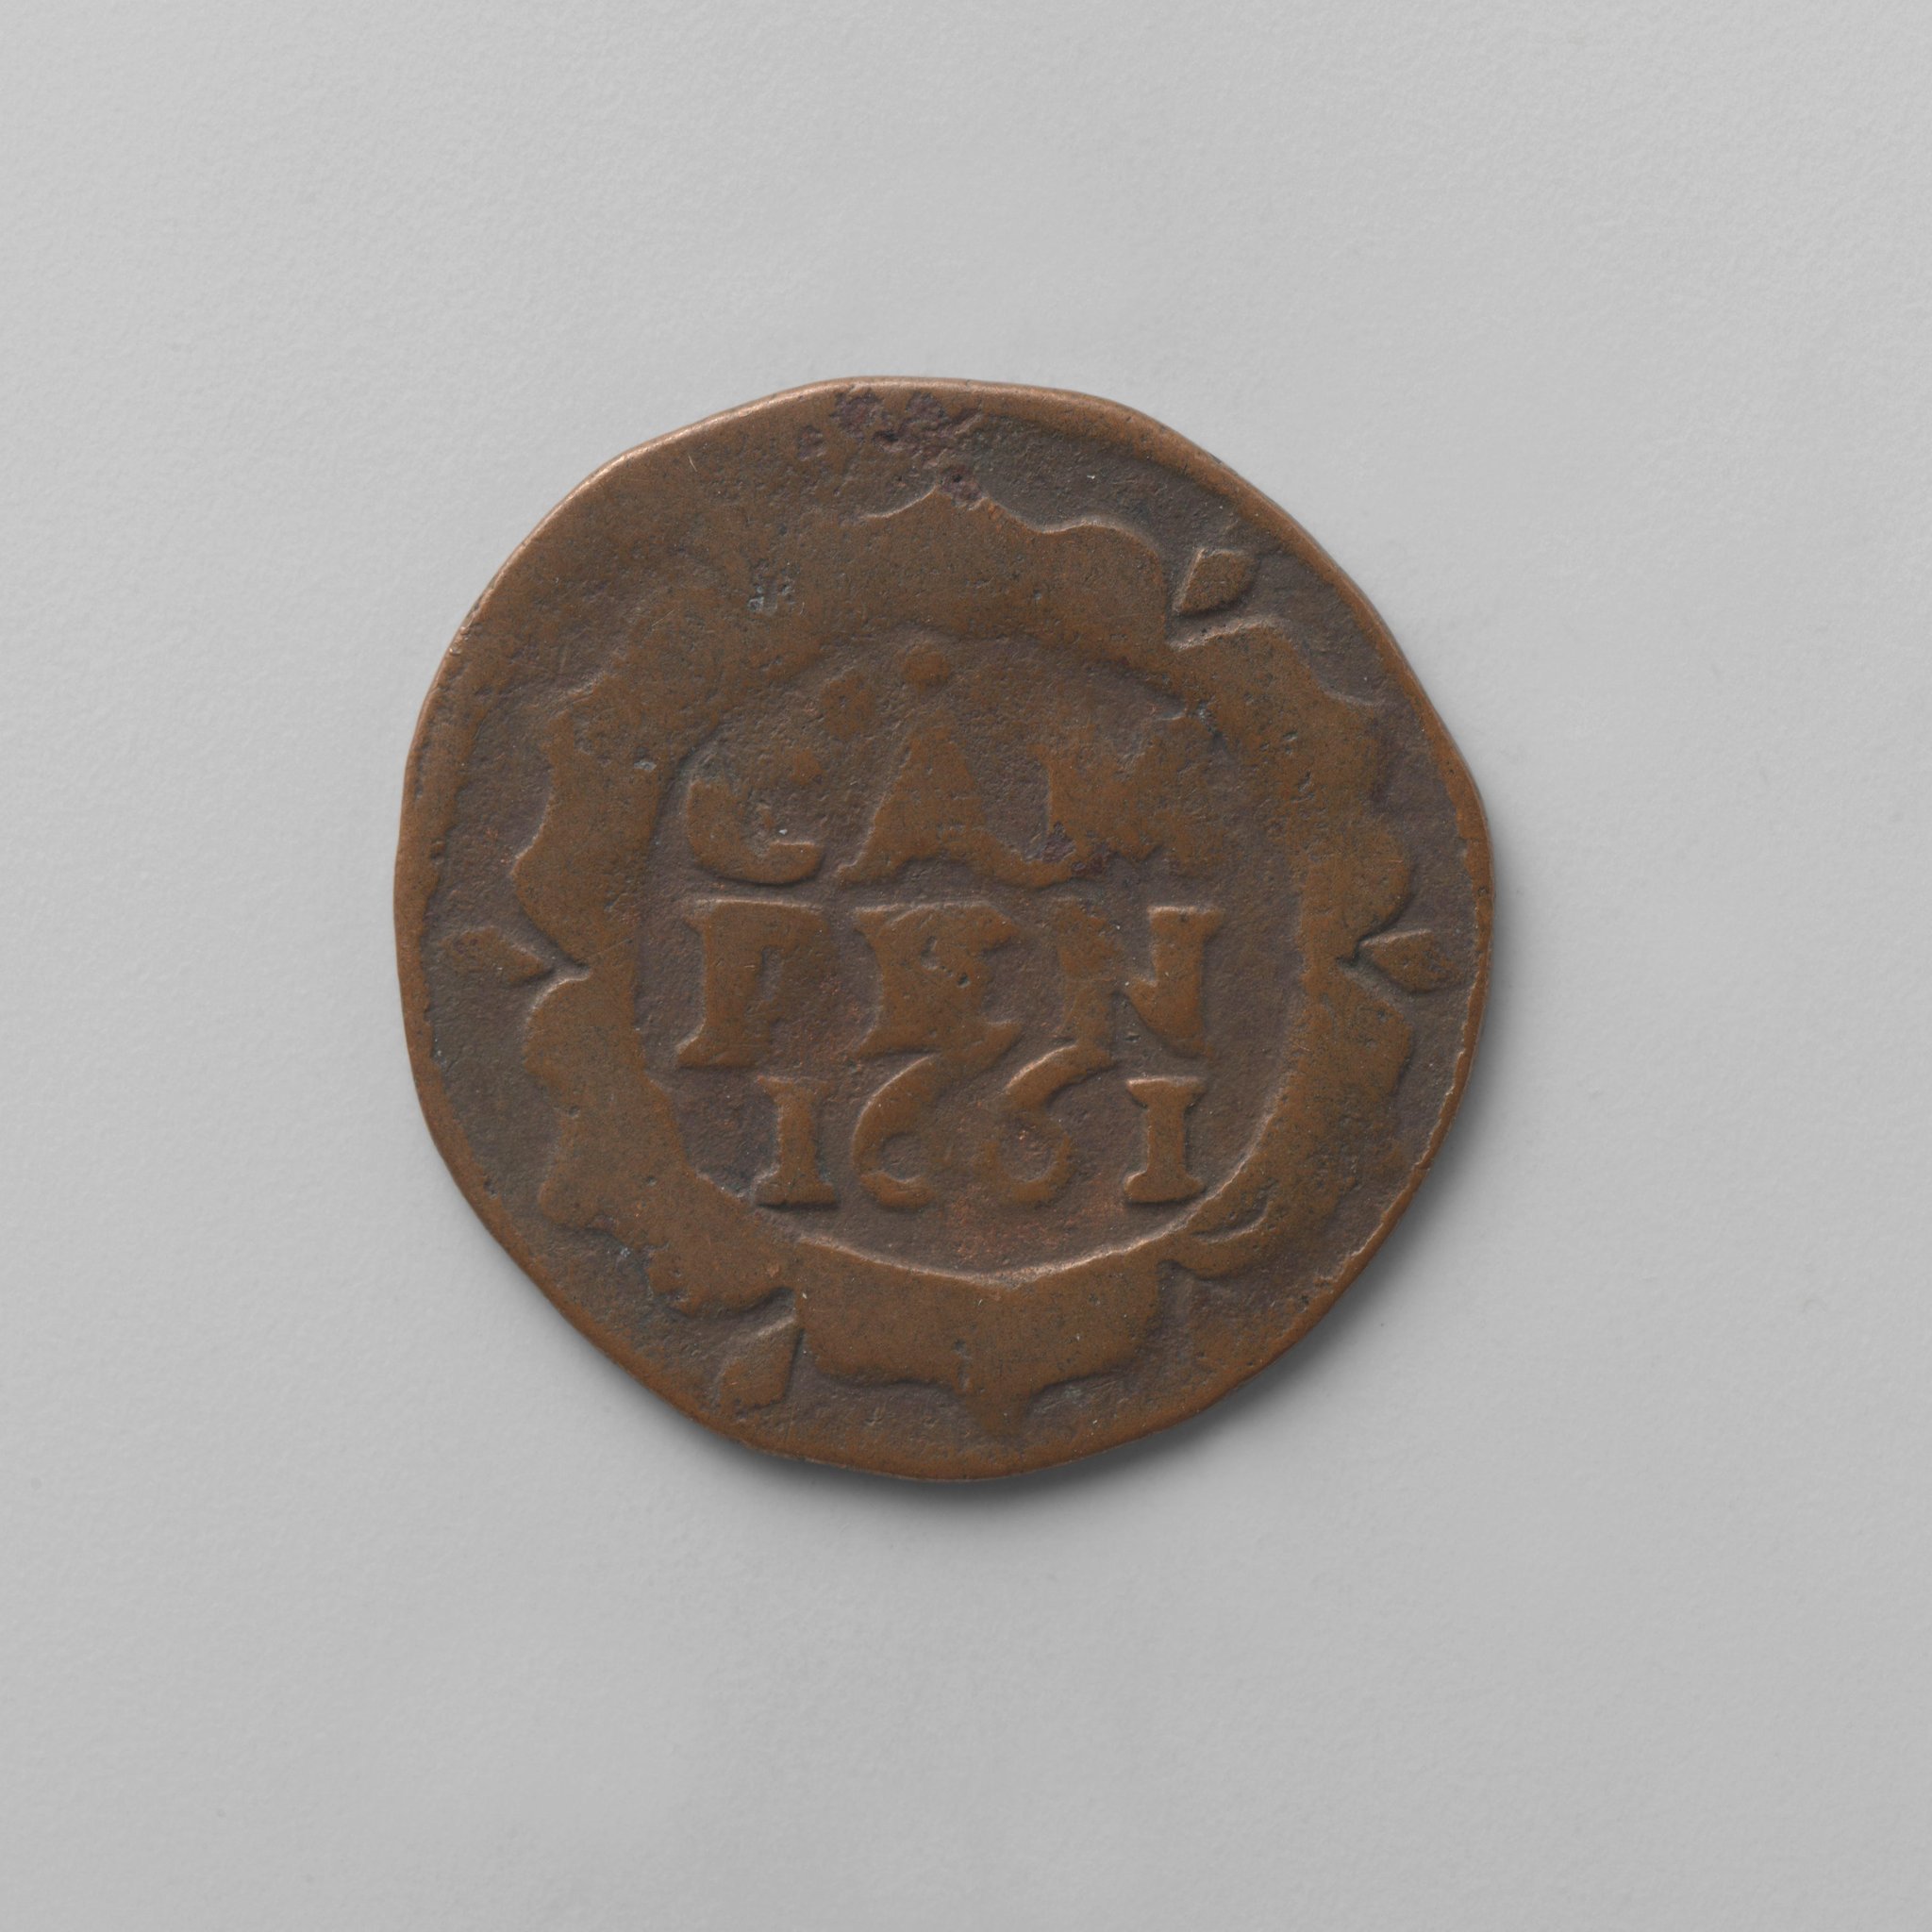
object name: coin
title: Kampen, duit, 1661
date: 1661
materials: copper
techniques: striking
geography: kampen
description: Koperen munt. Voorzijde: binnen een bladerkrans stadswapen. Keerzijde: binnen een versierde rand tweeregelig opschrift, waaronder jaartal.